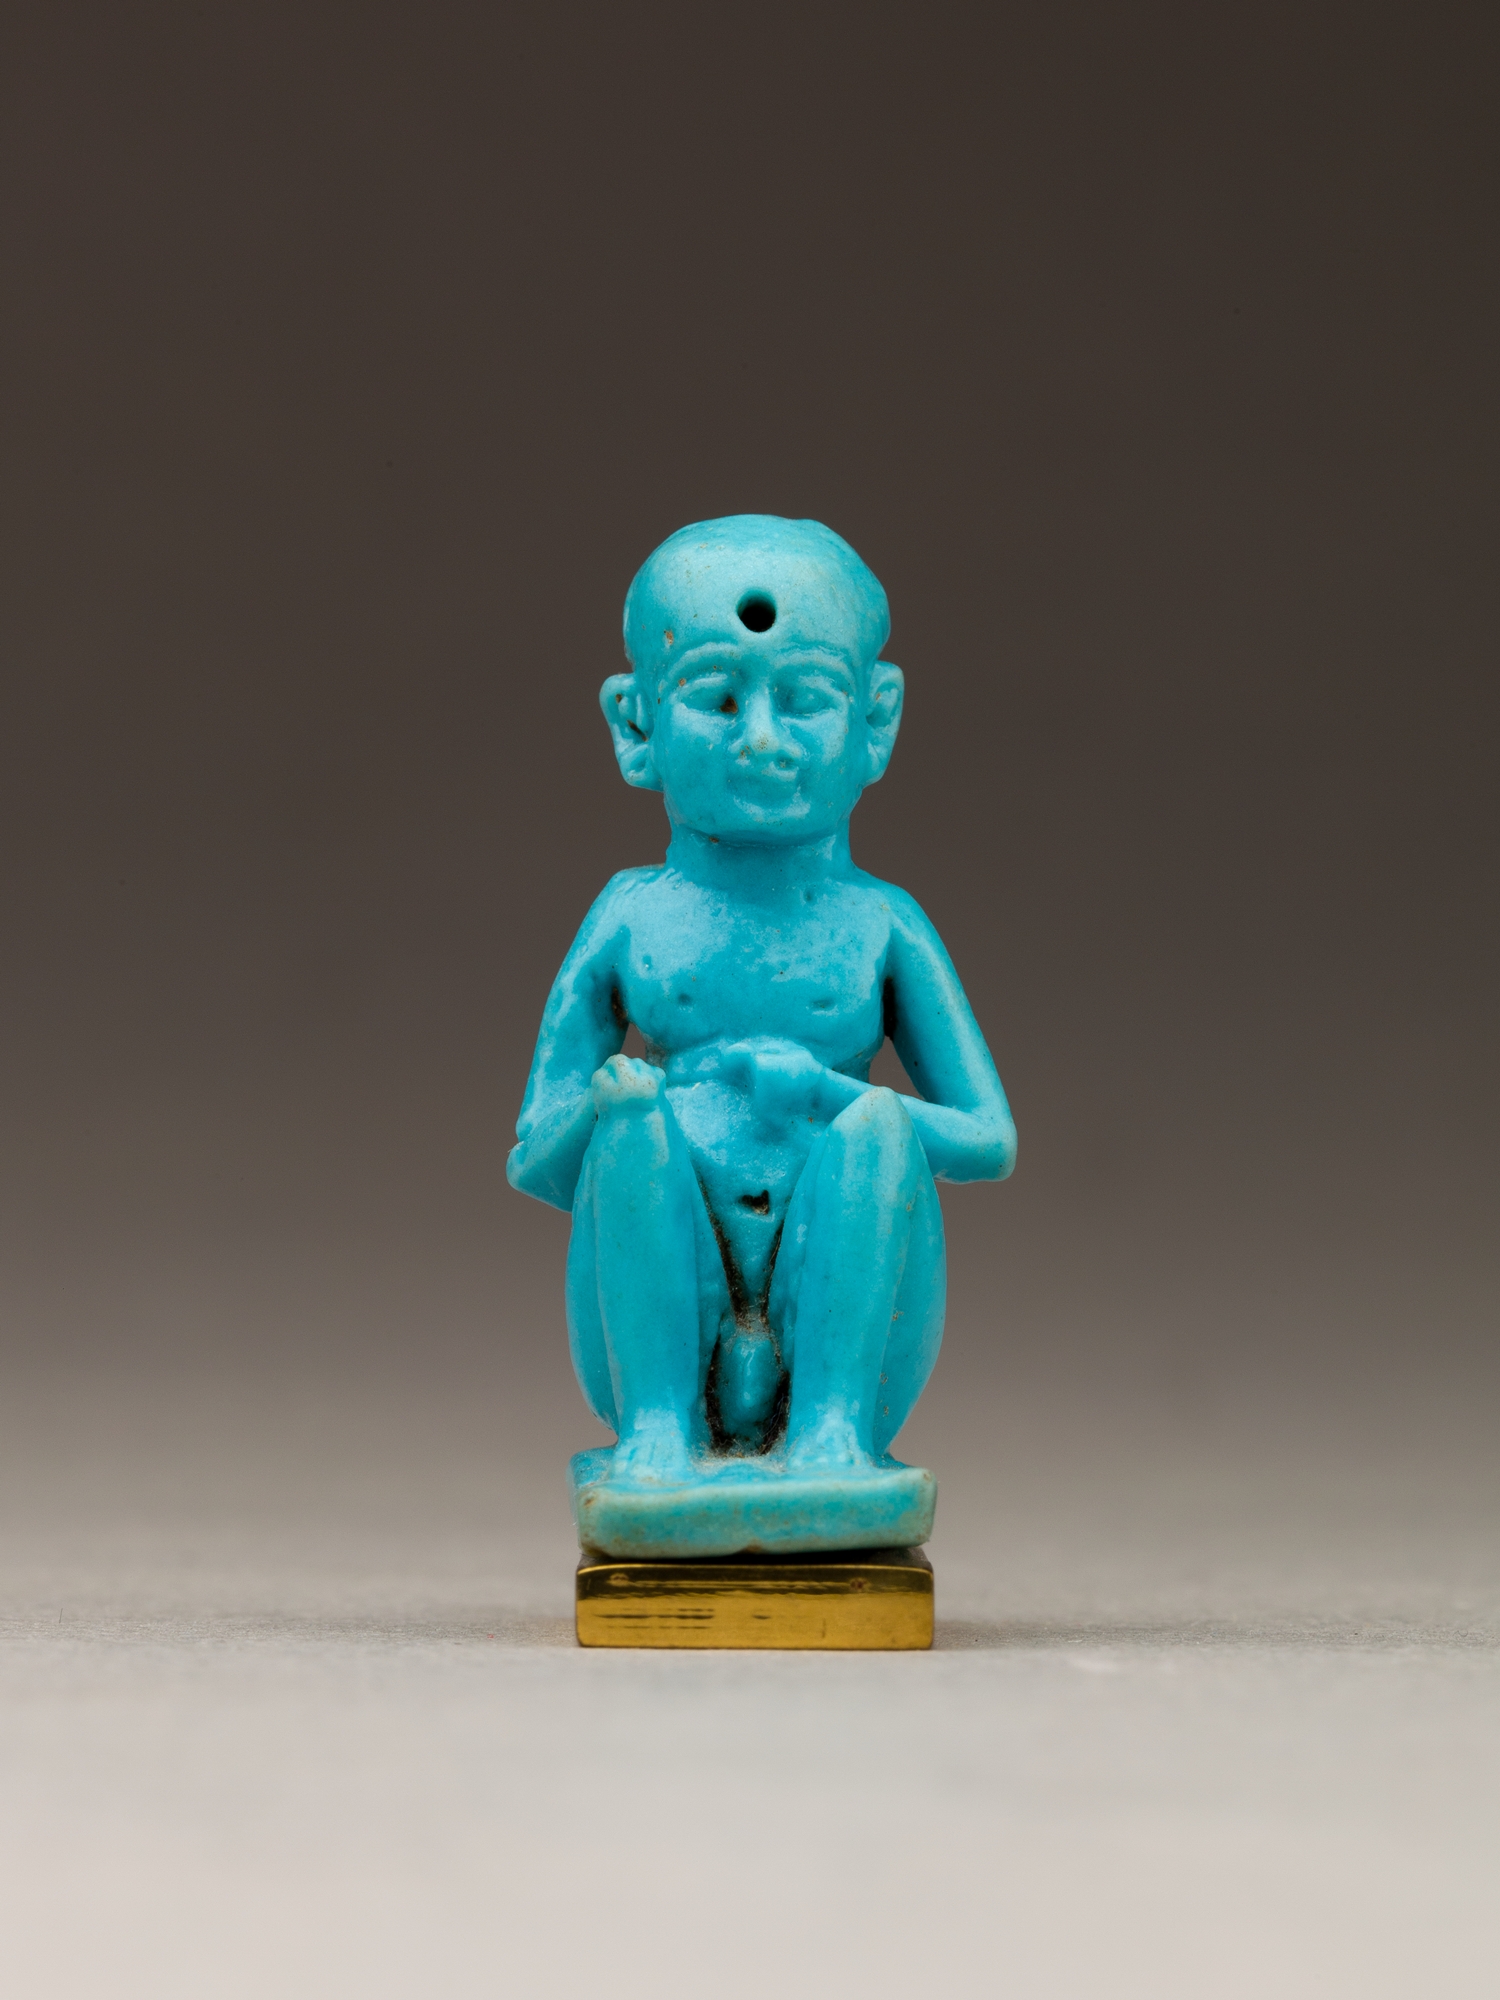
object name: amulet, horus a seated prince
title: Amulet: A Young Prince Represented as the Child Horus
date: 664-332 BCE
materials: faience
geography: egypt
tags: horus